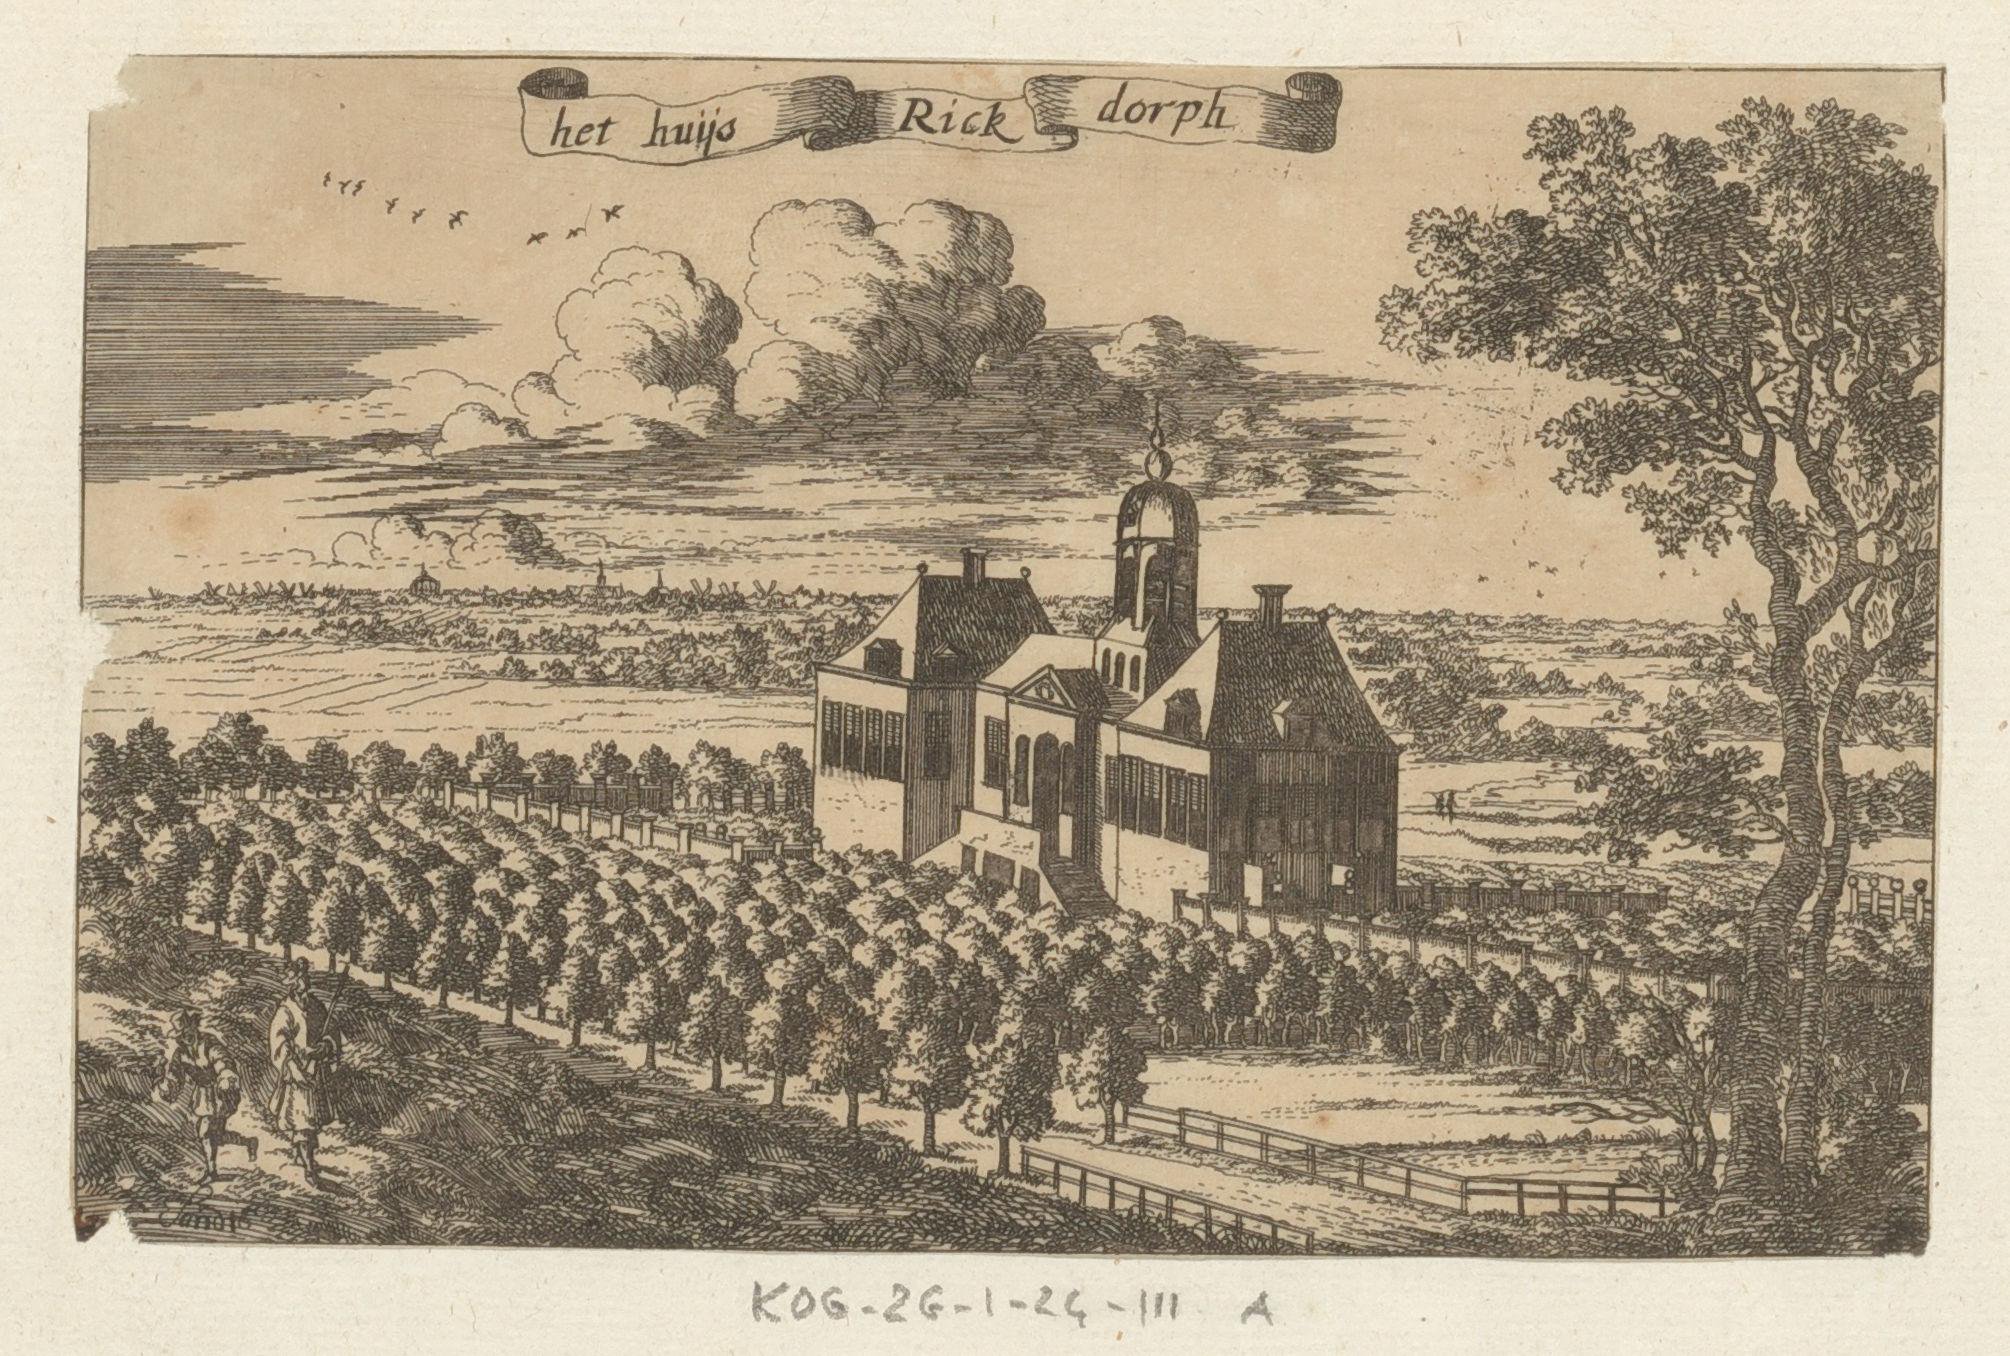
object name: print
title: Het huijs Rick dorph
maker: cornelis elandts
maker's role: draughtsman, painter, print maker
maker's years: 1641-1687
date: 1663-1670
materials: paper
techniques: etching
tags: castle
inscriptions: collector's mark: Lugt 1641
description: Landgoed Rickxdorp, het huidige Rijksdorp bij Wassenaar. Boven enkele rijen bomen steekt het landhuis uit, erachter de polder met enkele dorpjes. Op de voorgrond zijn twee mannen afgebeeld, waarvan er één een jachtgeweer vasthoudt. Onderwerpsrubrieken binnen de Atlas Zeden en Gewoonten: Zeden en Gewoonten in Engeren Zin, De Woning. Kastelen en buitenplaatsen. Over de Grenzen.